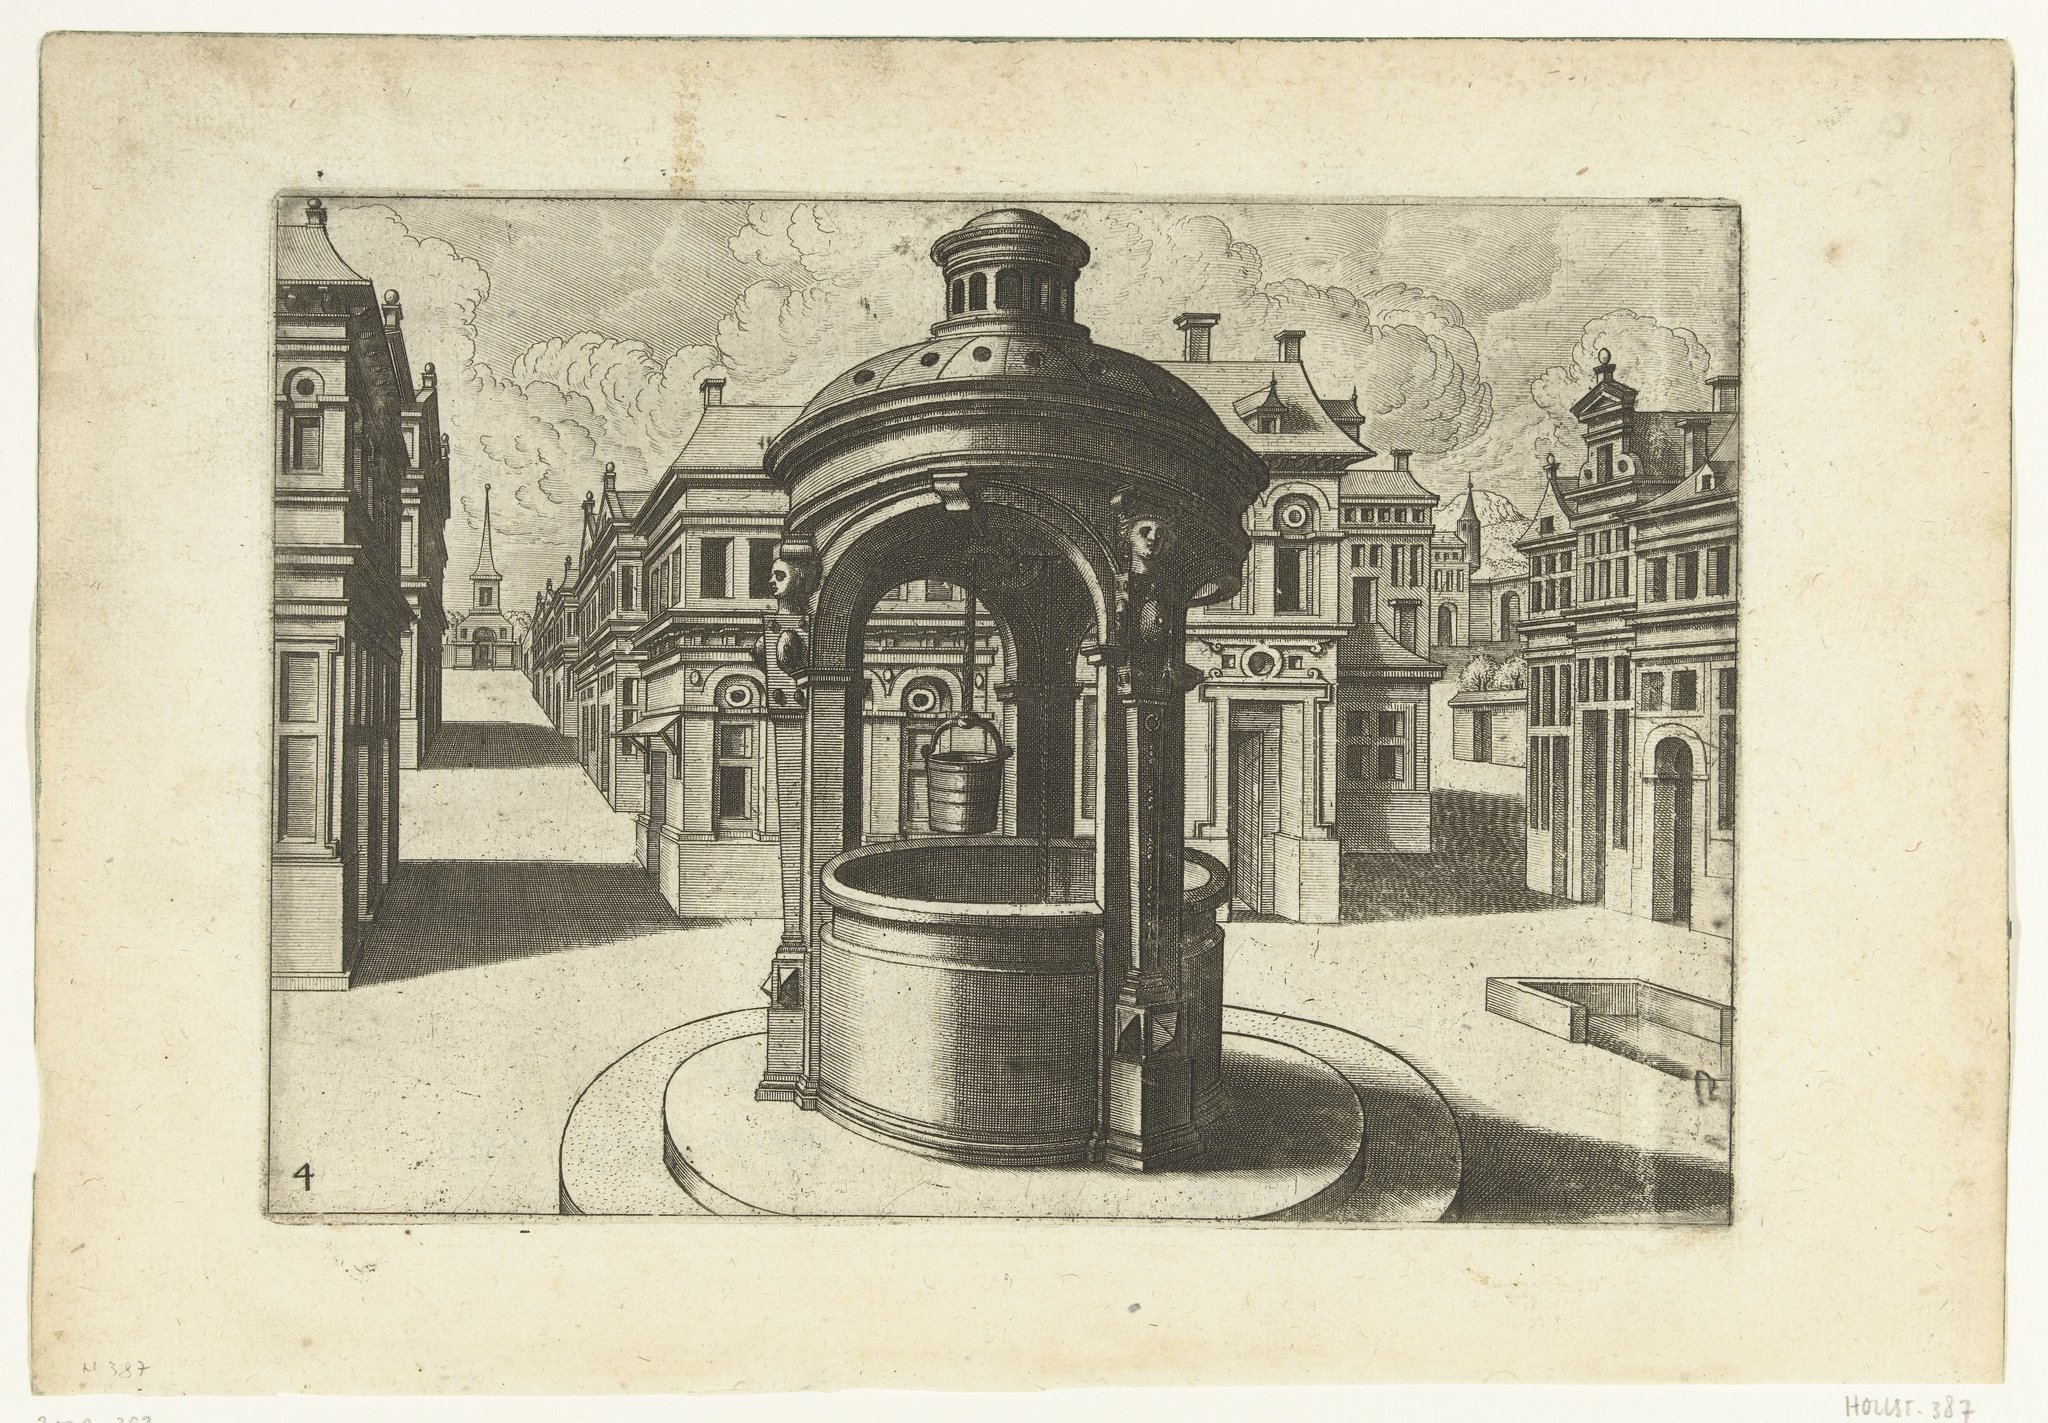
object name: ornament print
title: Waterputten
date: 1574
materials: paper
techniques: etching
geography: antwerp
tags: well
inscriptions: number: ‘4’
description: Stadsplein met een ronde put onder een koepel met een lantaarn. De koepel steunt op drie pilasters, gedecoreerd met hermen. Aan de katrol hangt een aker. No. 4 uit serie van 24 kleine waterputten.